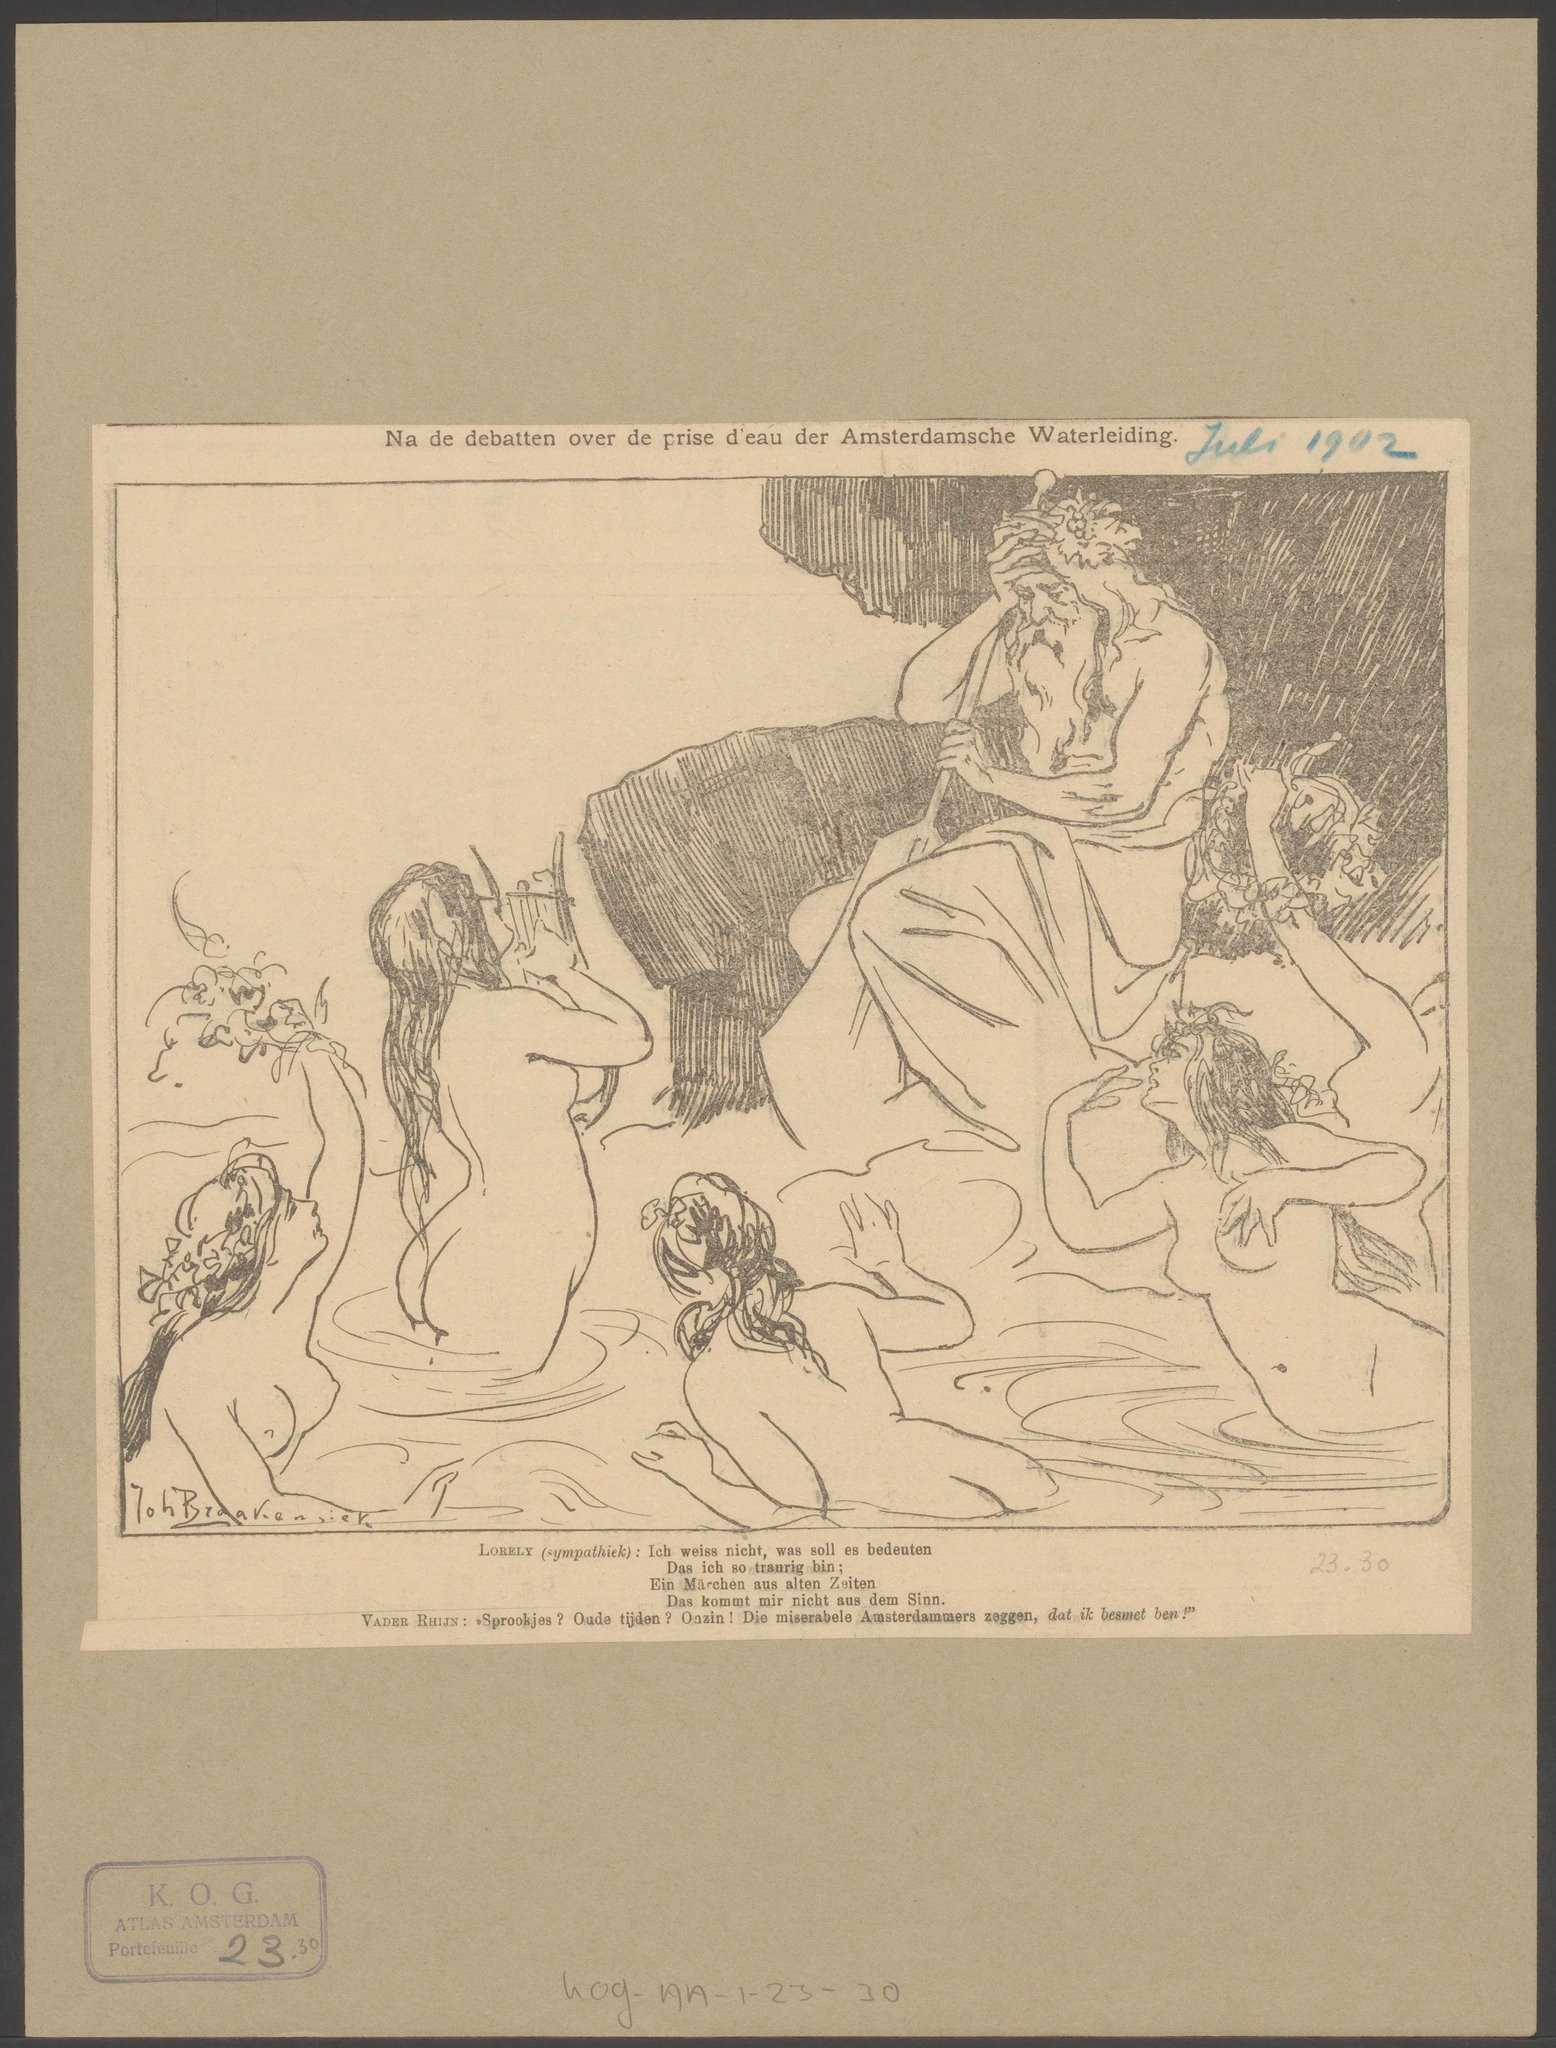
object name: photomechanical print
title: Na de debatten over de prise d'eau der Amsterdamsche Waterleiding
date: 1902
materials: paper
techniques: letterpress printing, line block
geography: amsterdam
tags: water-supply (~ public services), river personified, 'fiumi' (ripa), river personified: rhine, amsterdam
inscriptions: collector's mark: Lugt 1641b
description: Prent uit: De Amsterdammer 26 (1902), nr. 1309, 27 juli 1902, p. 9.